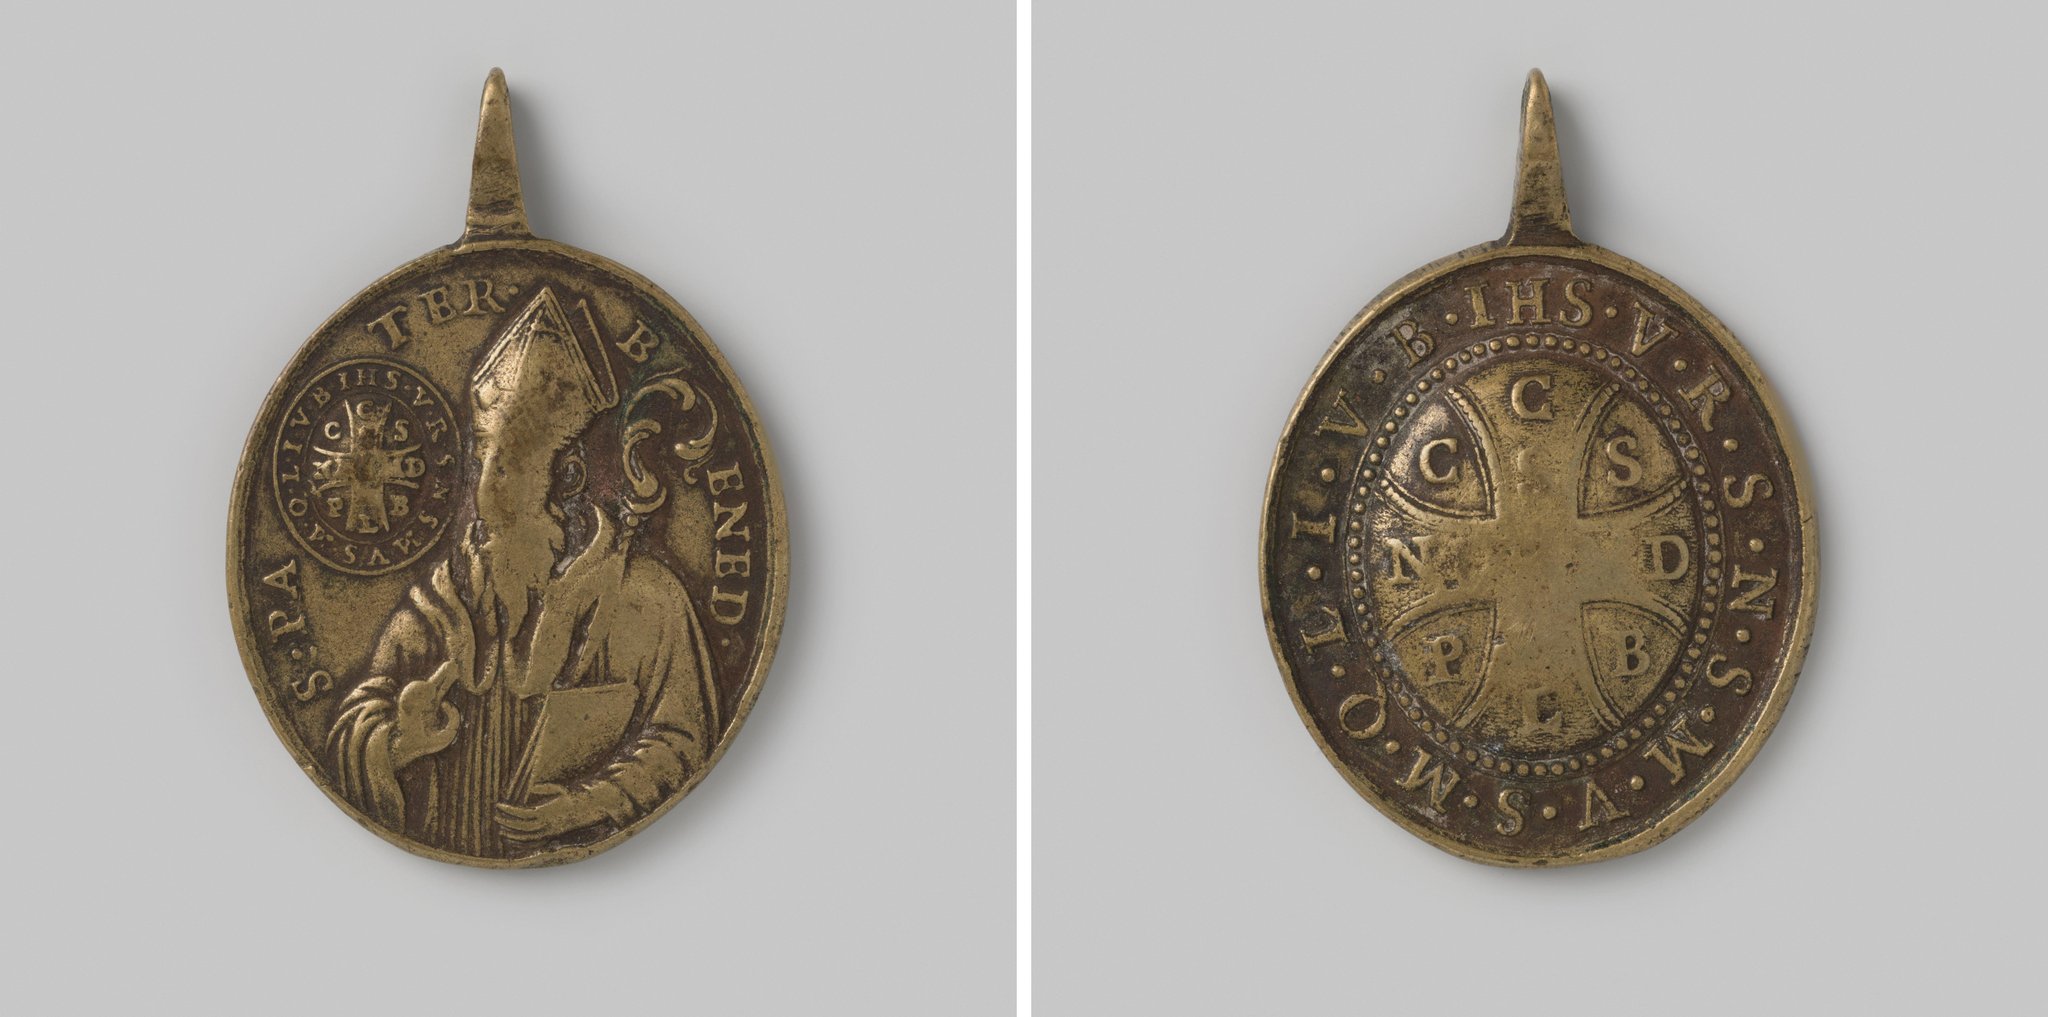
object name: history medal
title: Religieus draagteken met St. Pater Benedictus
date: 1750-1850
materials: brass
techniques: casting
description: Ovalen messing penning met draagoog, op de voorzijde Sint Benedictus als bisschop ten halven lijve half naar links, links het medaillon van Benedictus, met omschrift, op de keerzijde het medaillon van Benedictus met omschrift.